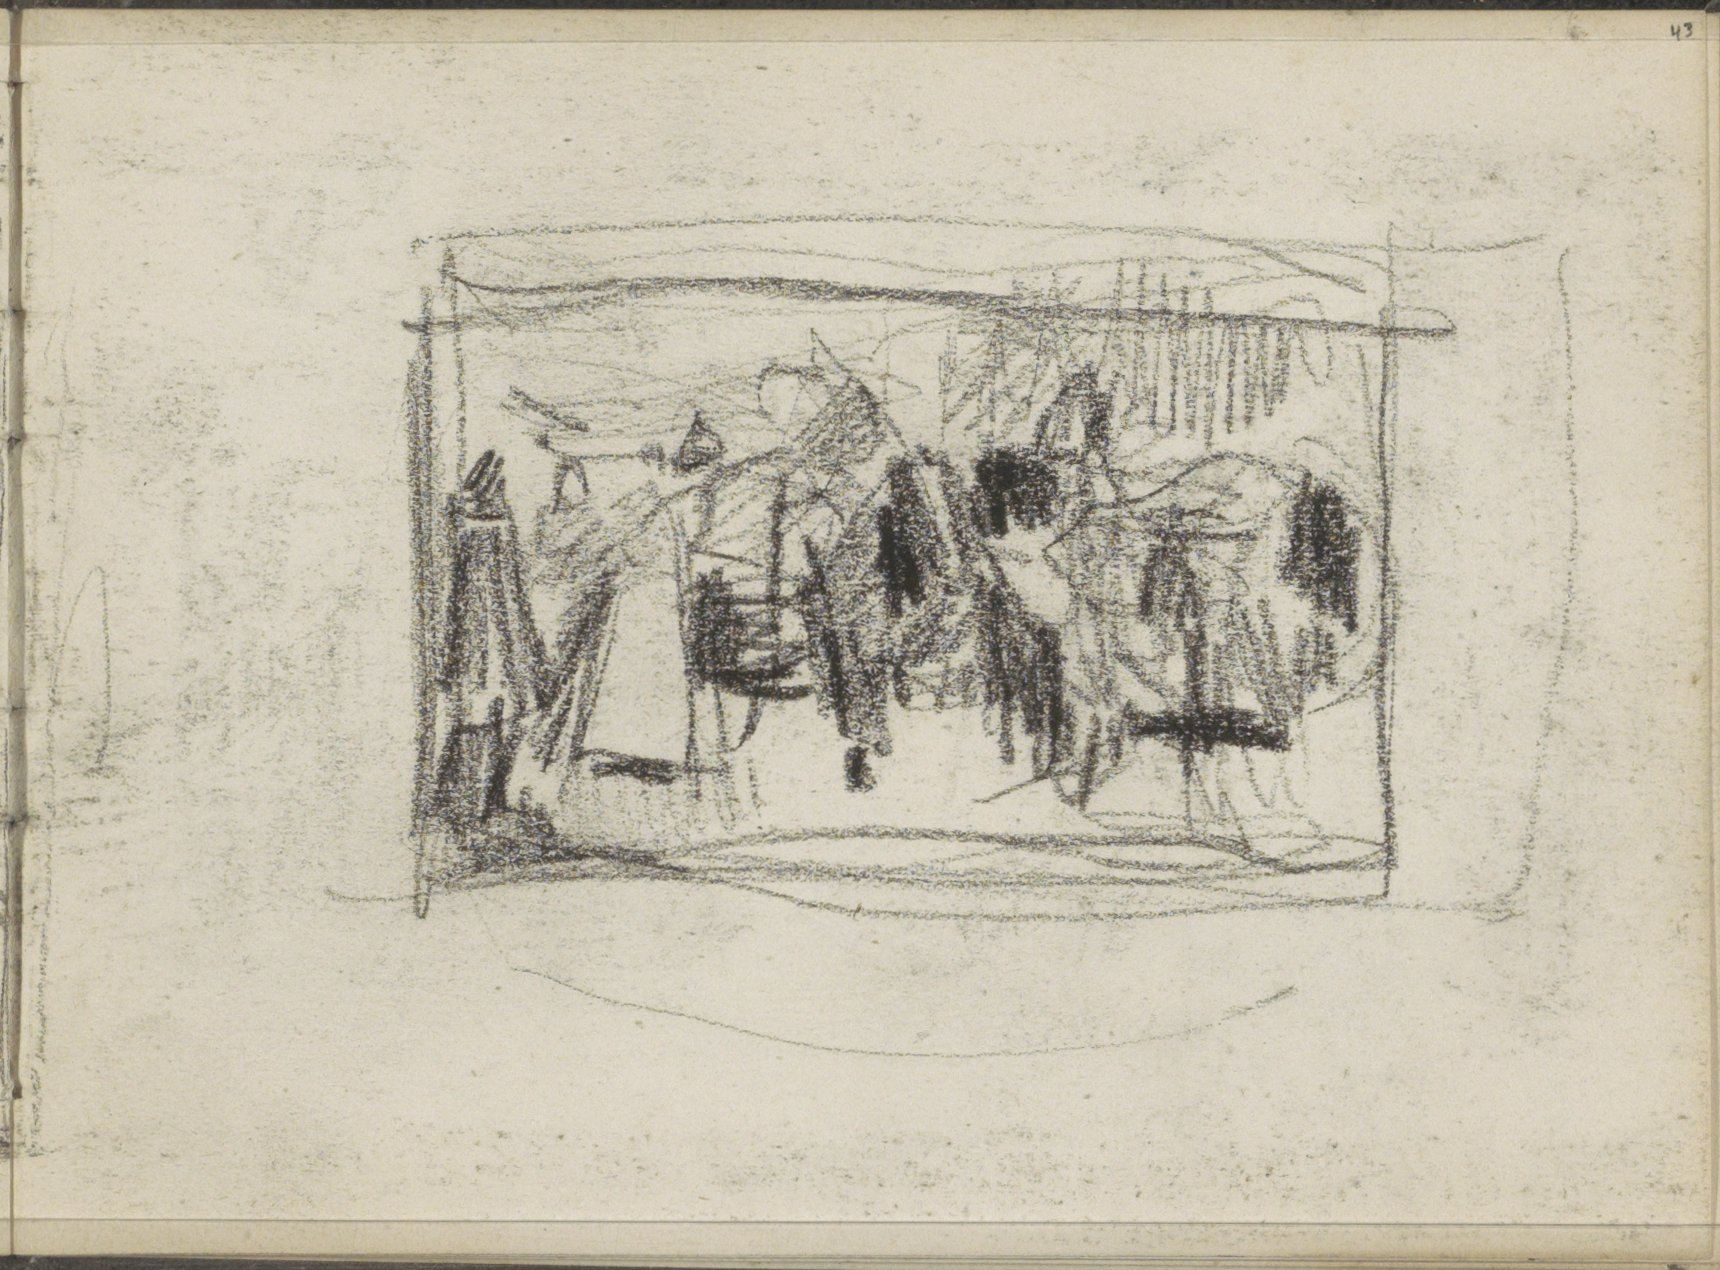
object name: sketchbook leaf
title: Straat met figuren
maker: marius bauer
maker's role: draughtsman, print maker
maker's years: 1867-1932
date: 1877-1932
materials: chalk, paper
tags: street (+ city(-scape) with figures, staffage)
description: Pagina 43 uit een schetsboek met 32 bladen.